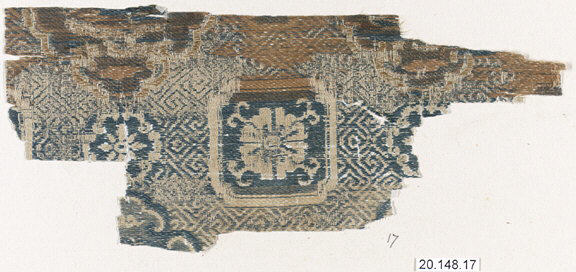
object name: piece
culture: japanese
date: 1101-1200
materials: silk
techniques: compound weave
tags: flowers